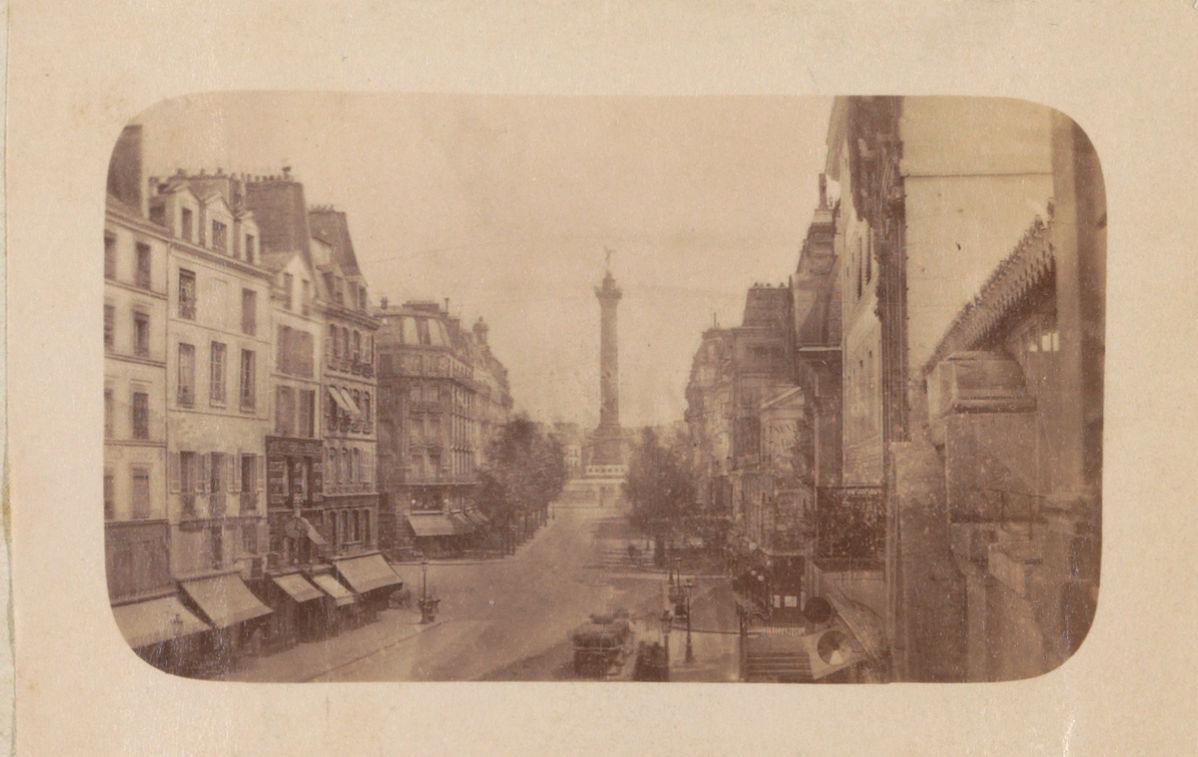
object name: photograph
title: Straatgezicht in Parijs met op de achtergrond de Colonne de Juillet op de Place de la Bastille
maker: Anonymous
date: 1883-1886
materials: photographic support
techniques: albumen print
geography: france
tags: monument, statue (+ city(-scape) with figures, staffage), street (+ city(-scape) with figures, staffage), paris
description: Onderdeel van Album van een Franse amateurfotograaf met opnames van familie, militairen, industrie, landschappen en bezienswaardigheden in Frankrijk.